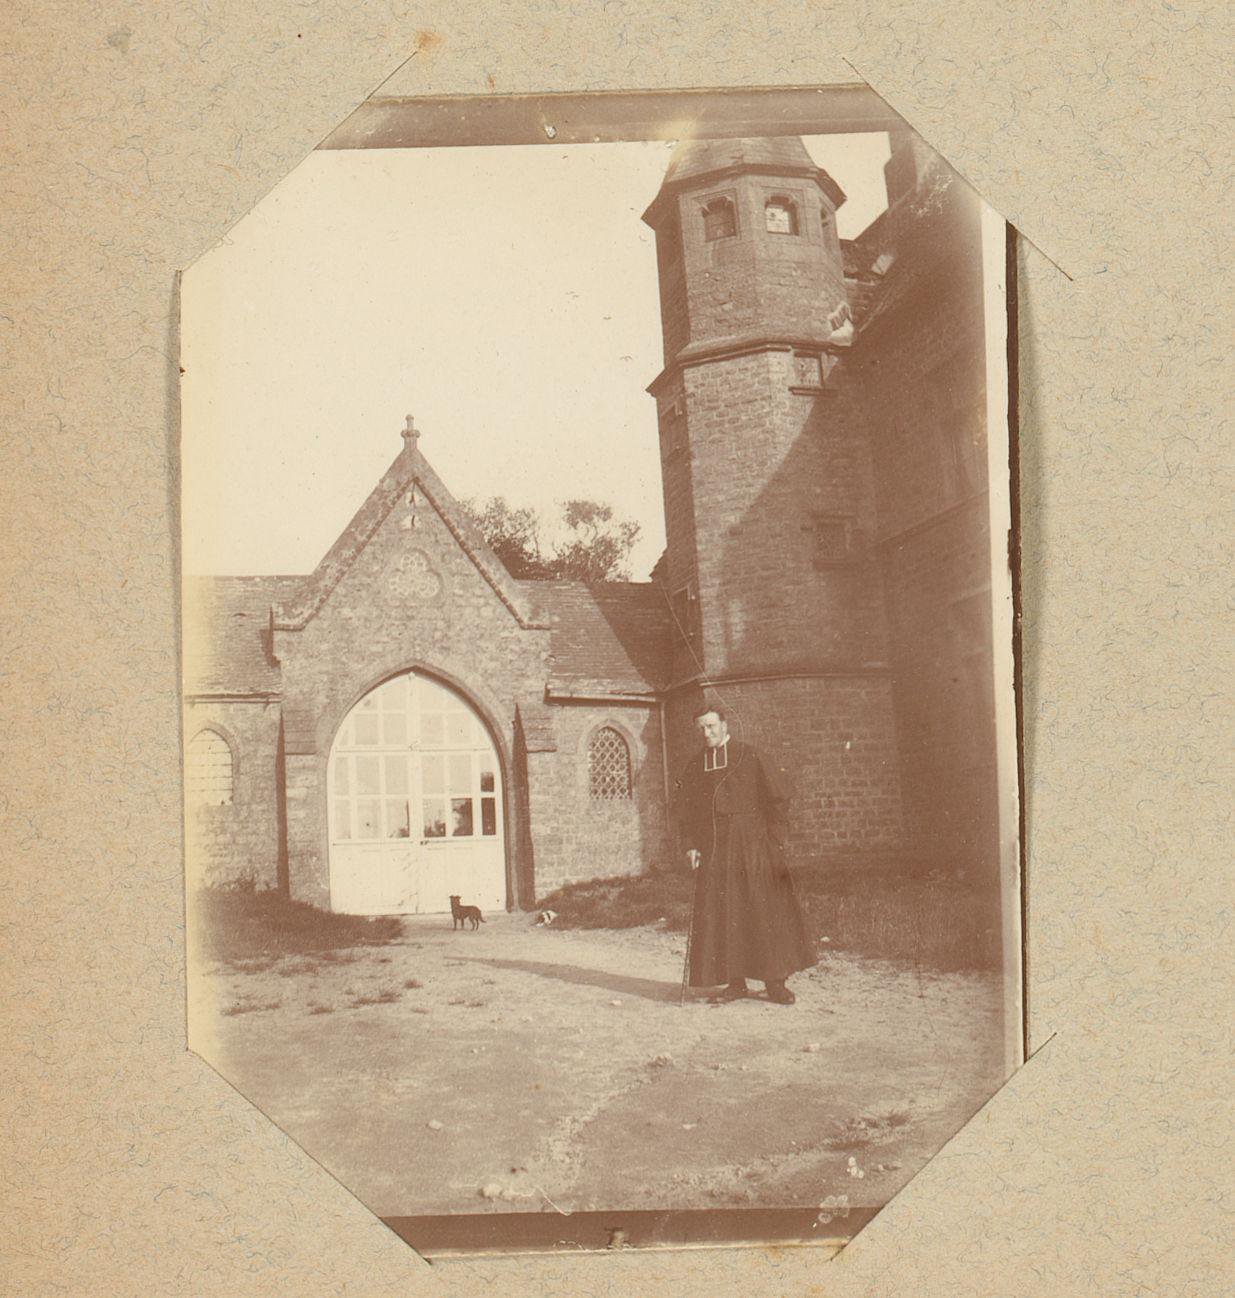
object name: photograph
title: Geestelijke voor een klooster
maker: Anonymous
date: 1897-1900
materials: paper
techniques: gelatin silver print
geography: france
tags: abbey, monastery, convent ~ roman catholic church, regular clerics, e.g. jesuits, redemptorists, france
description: Over de foto is een ander negatief afgedrukt van een voorstelling van bomen.